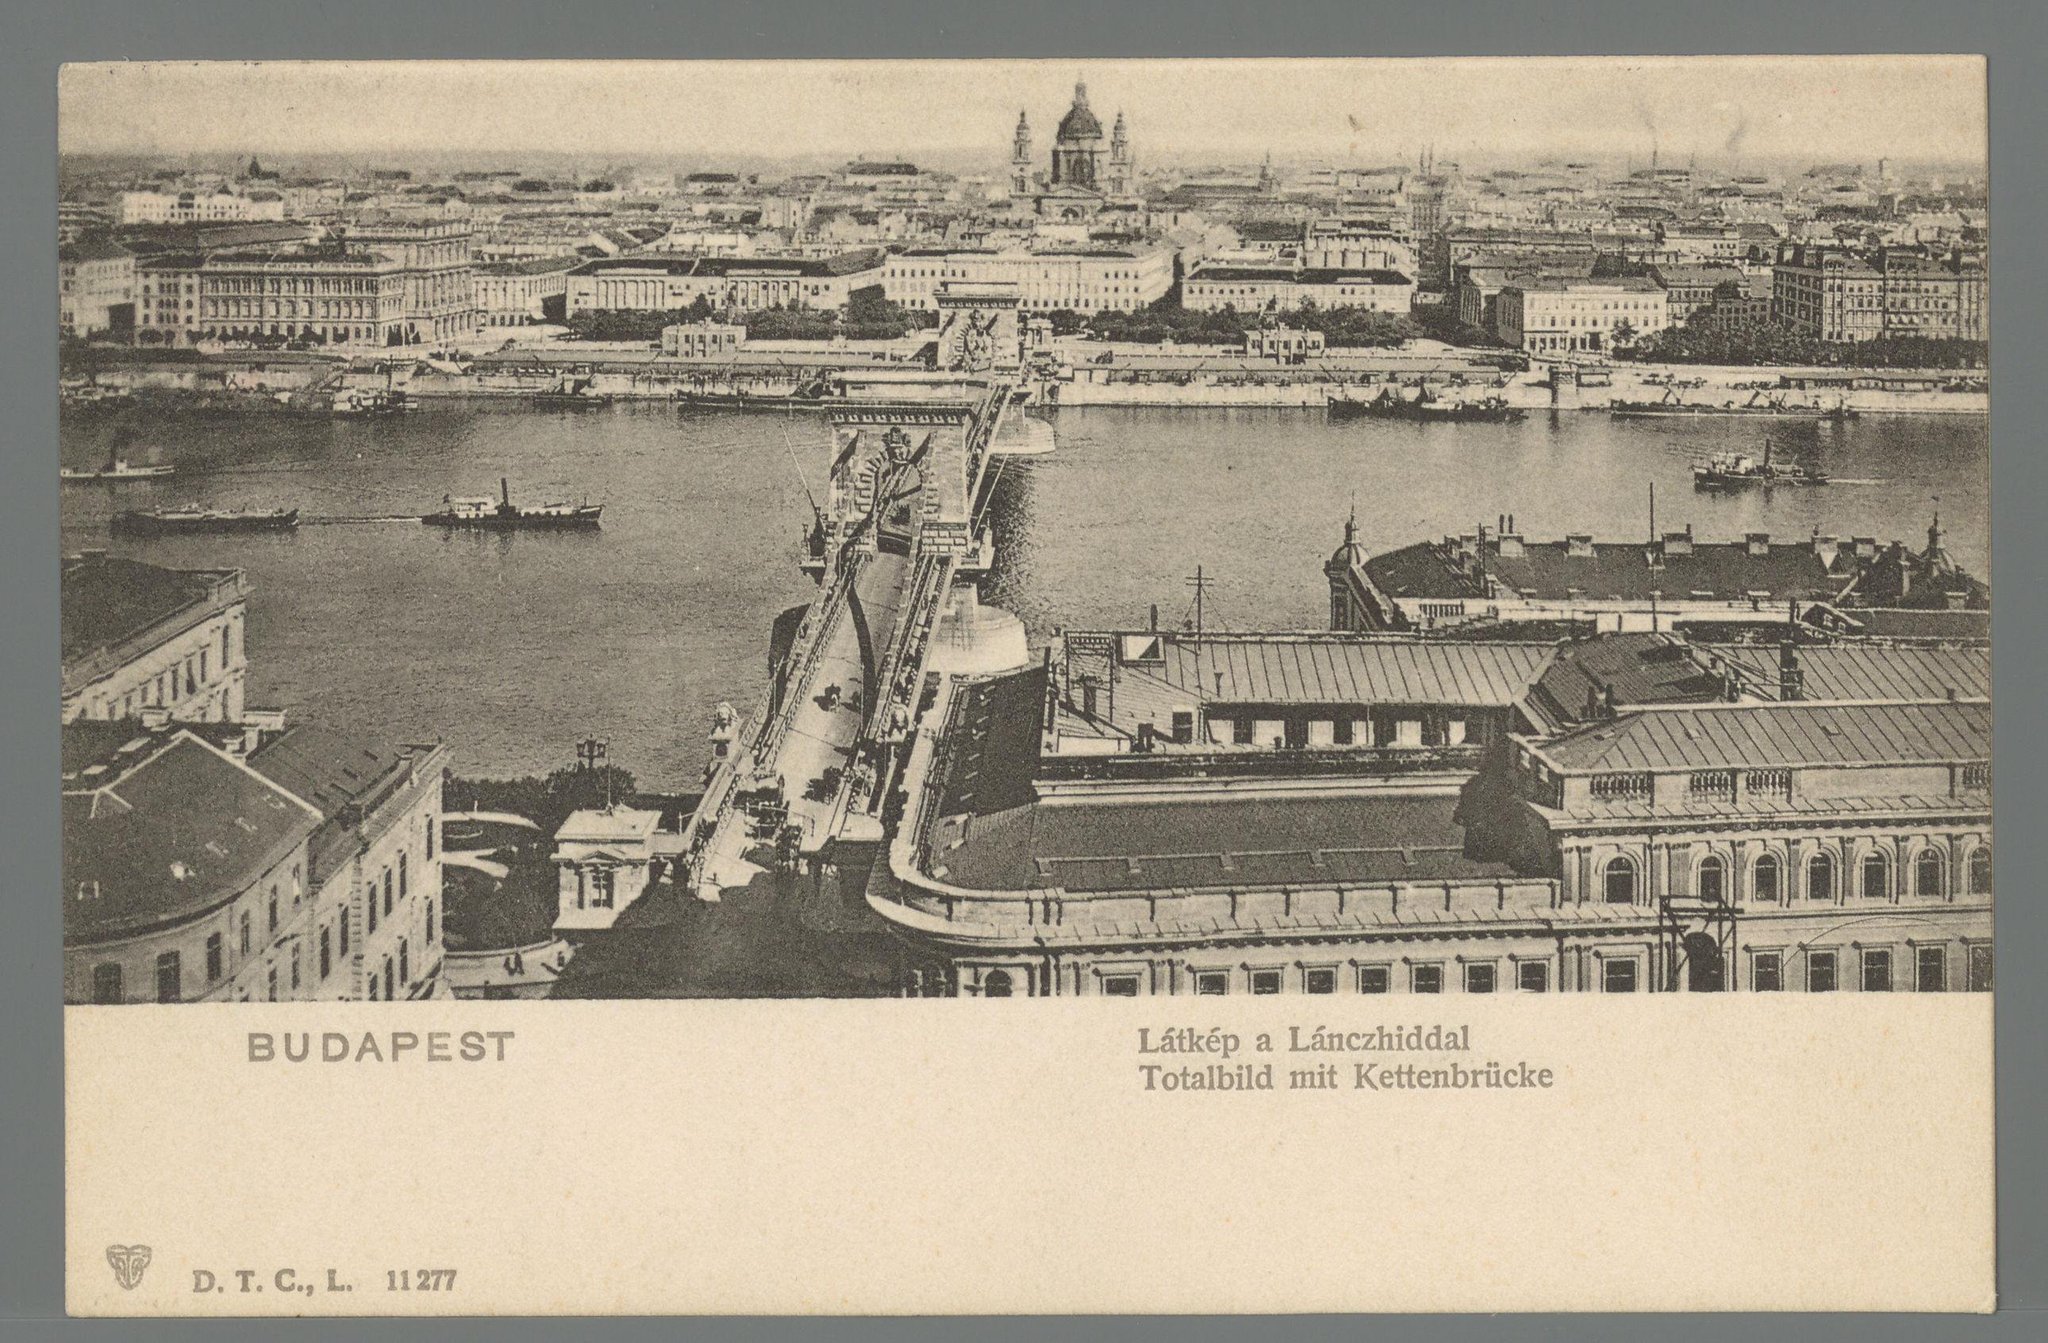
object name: photomechanical print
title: Budapest. Látkép a Lánczhiddal / Totalbild mit Kettenbrücke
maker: Anonymous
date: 1894-1903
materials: cardboard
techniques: photograph, writing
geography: leipzig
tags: canals, waters (in city), bridge in city across river, canal, etc., prospect of city, town panorama, silhouette of city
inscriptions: postage stamp